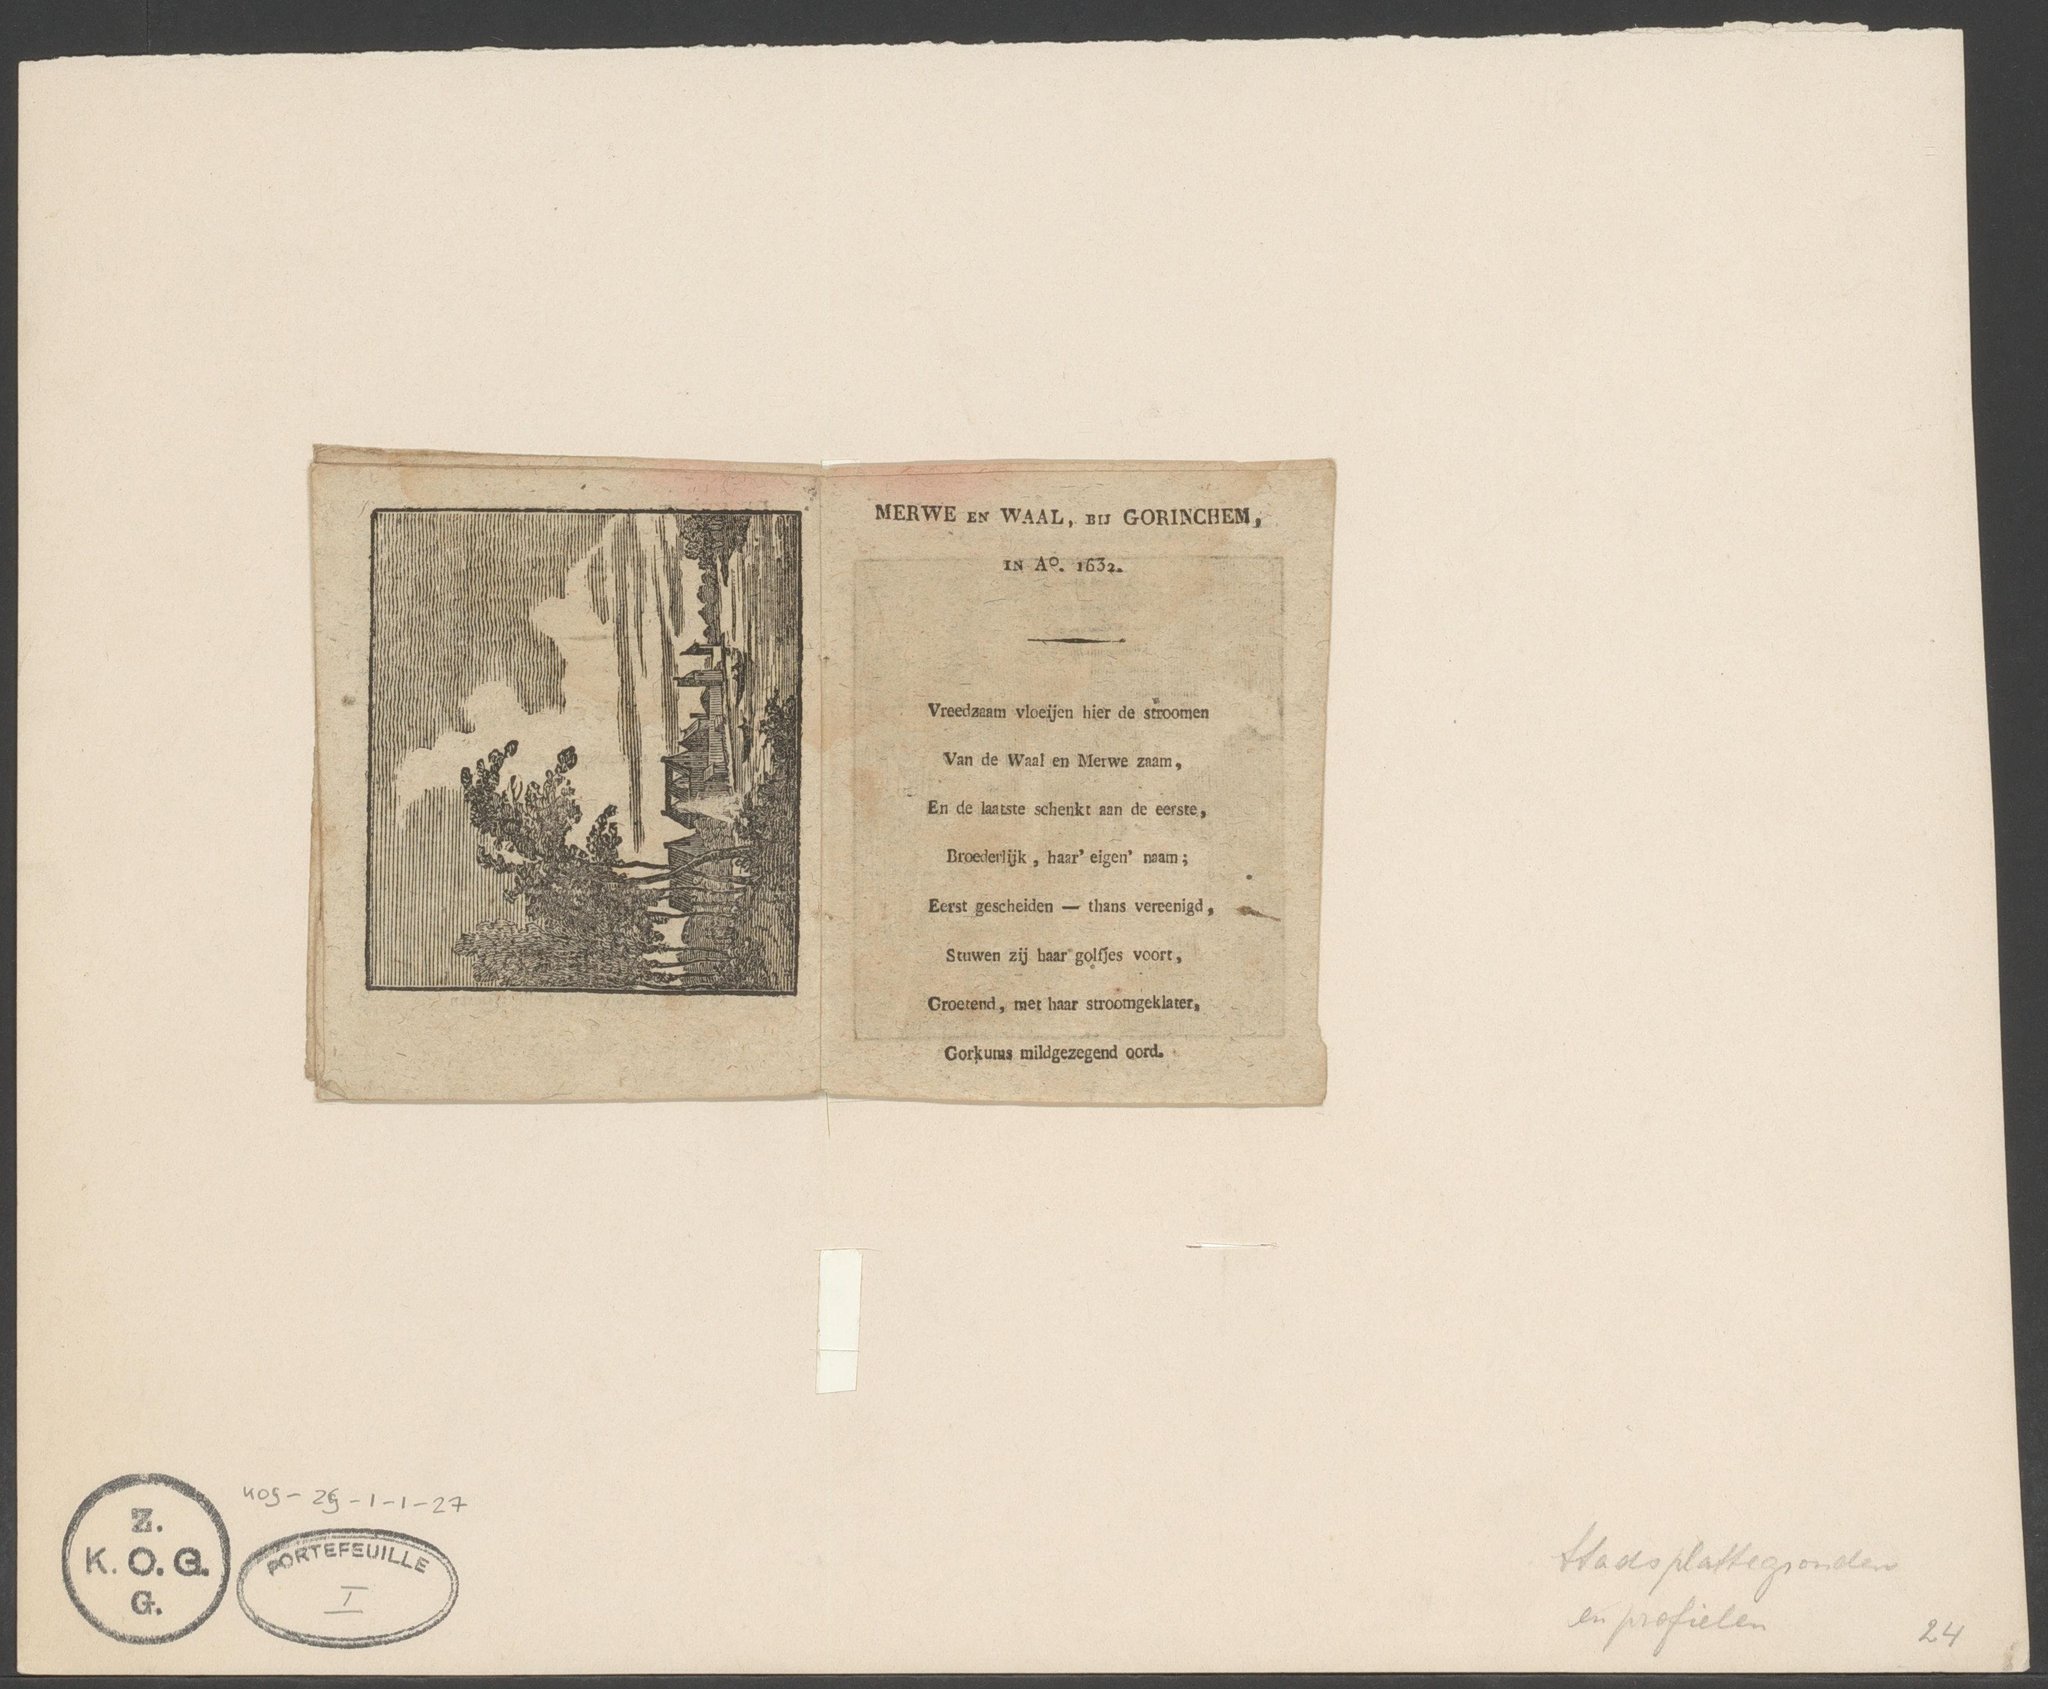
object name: print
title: Prentverbeeldingen van een zevental Gezigten op Rivieren van ons Vaderland; met toepasselijke Bijschriften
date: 1837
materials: paper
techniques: letterpress printing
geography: netherlands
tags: river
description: Rivierlandschap met de Merwede bij Gorinchem, met achtregelig vers. Onderdeel van een gevouwen boekje met zeven gezichten met Nederlandse rivierlandschappen met bijpassende verzen met jaartallen. Onderwerpsrubrieken binnen de Atlas Zeden en Gewoonten: topografie.